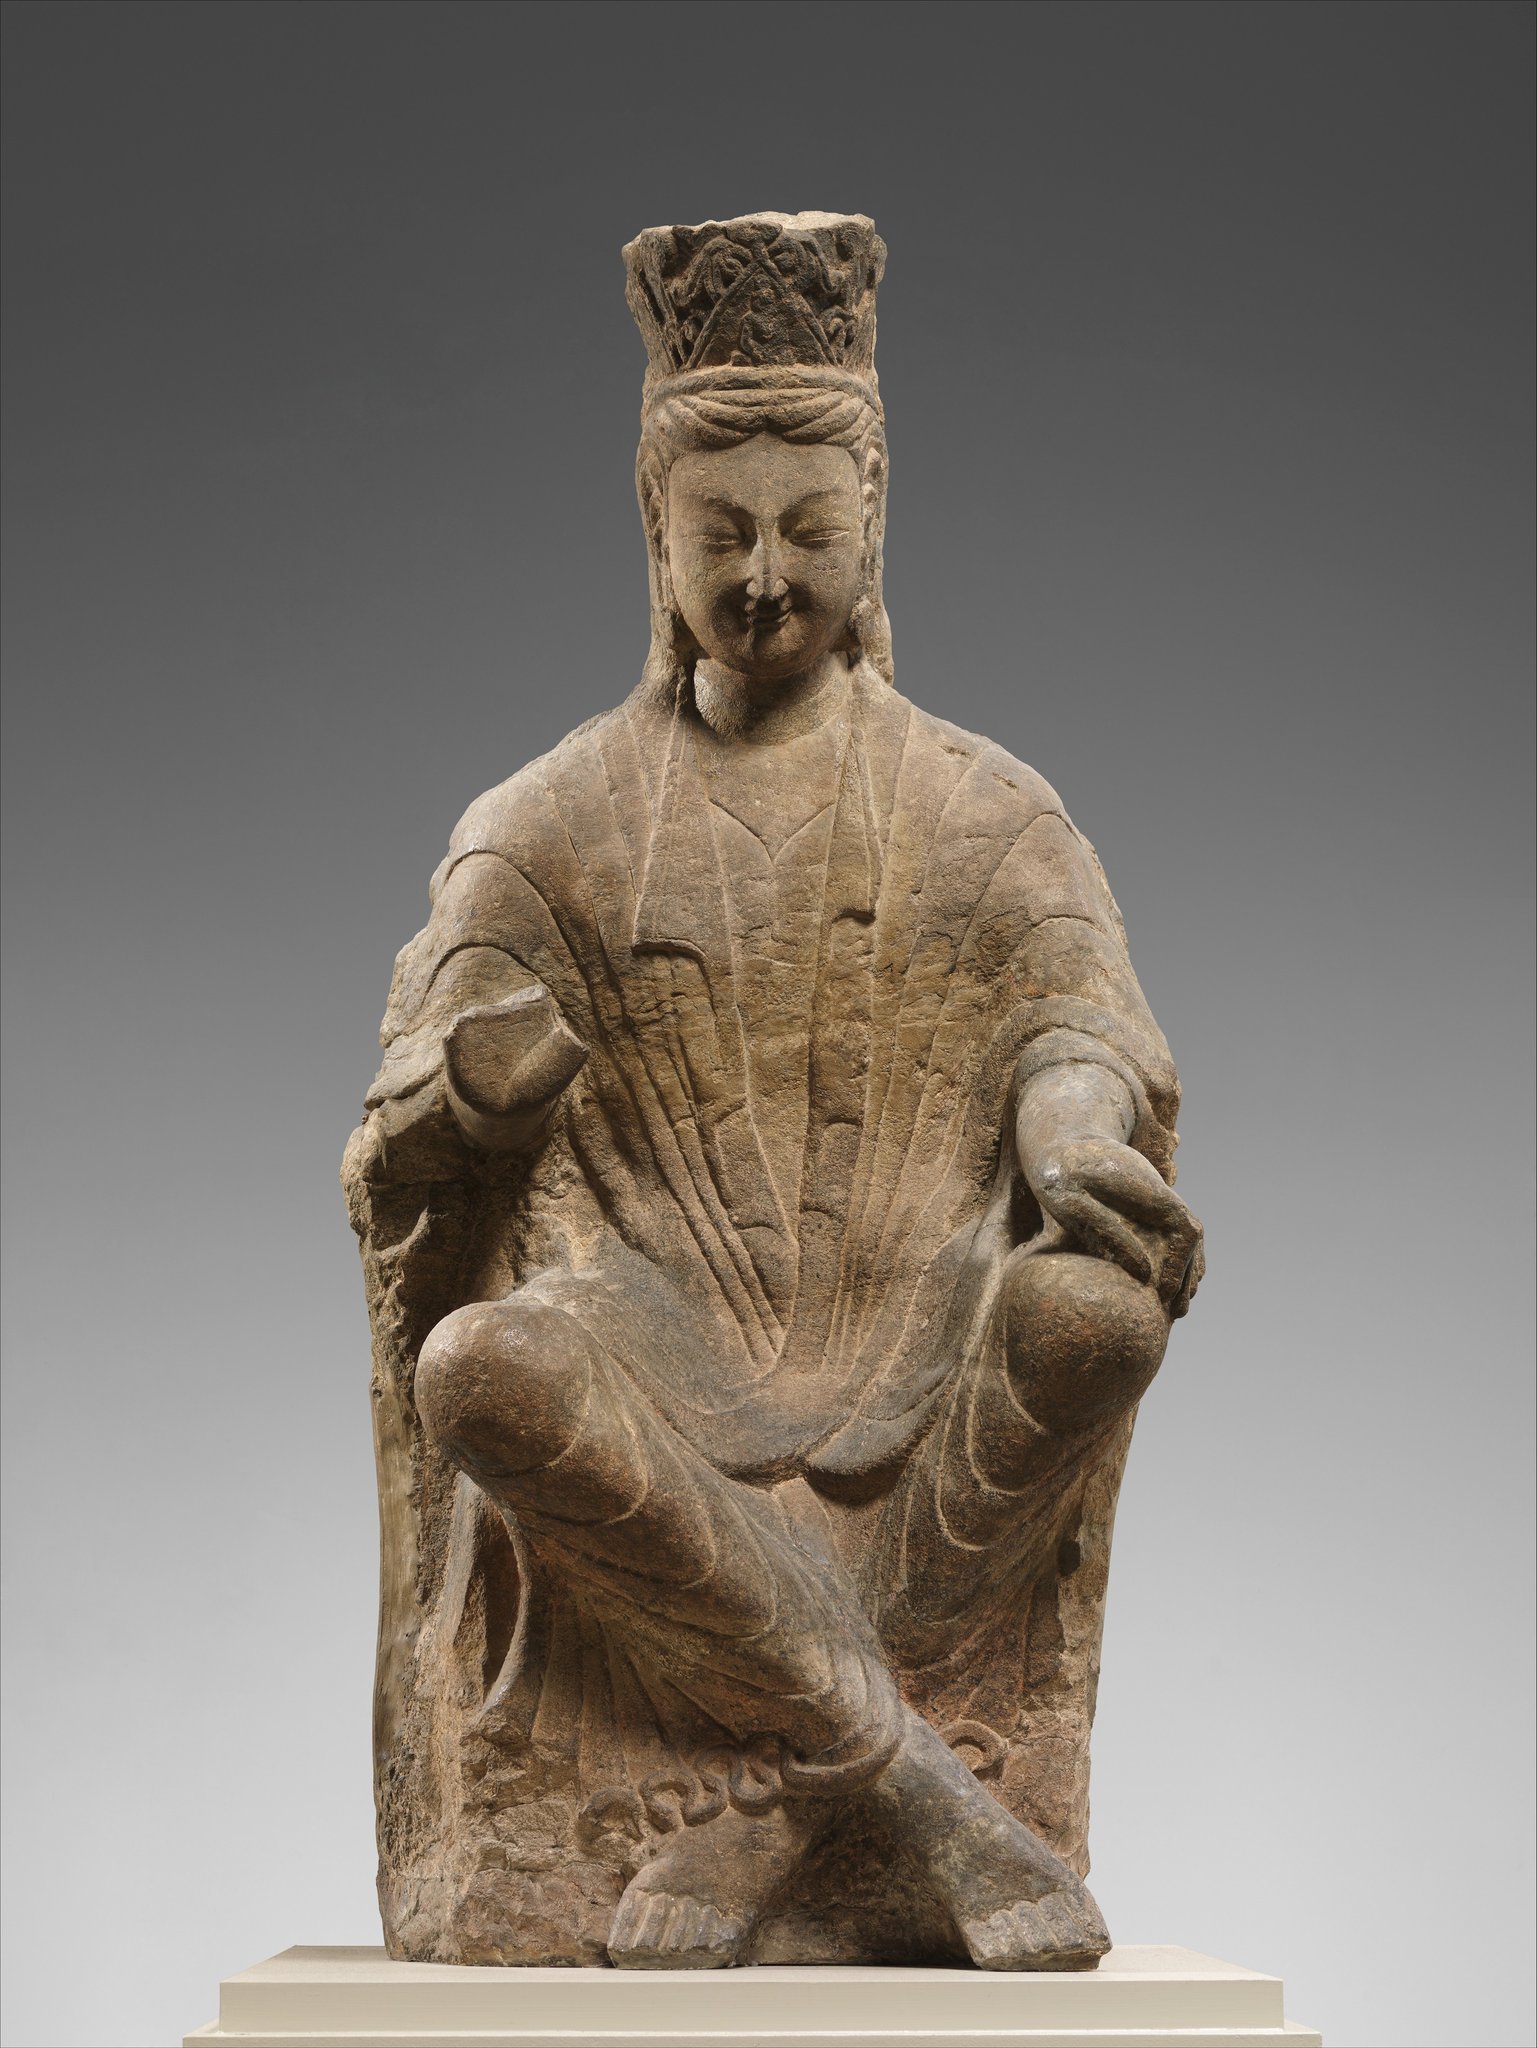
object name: figure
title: Bodhisattva (Maitreya) with crossed ankles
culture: chinese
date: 470-480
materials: pigment, stone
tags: buddhism,bodhisattvas